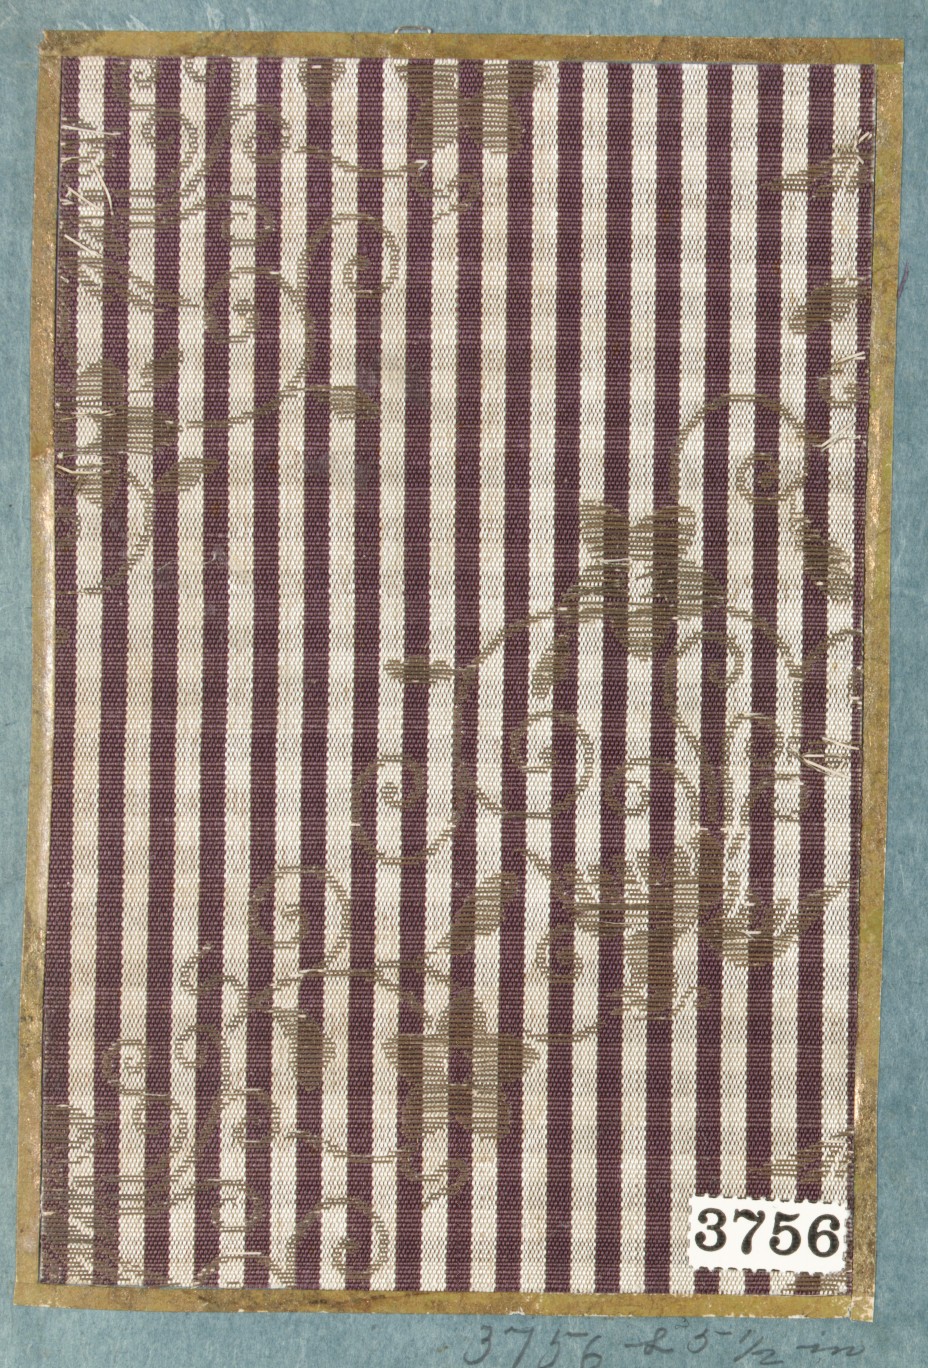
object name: sample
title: Textile Sample from Sample Book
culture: japanese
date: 1801-1900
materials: silk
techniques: tapestry